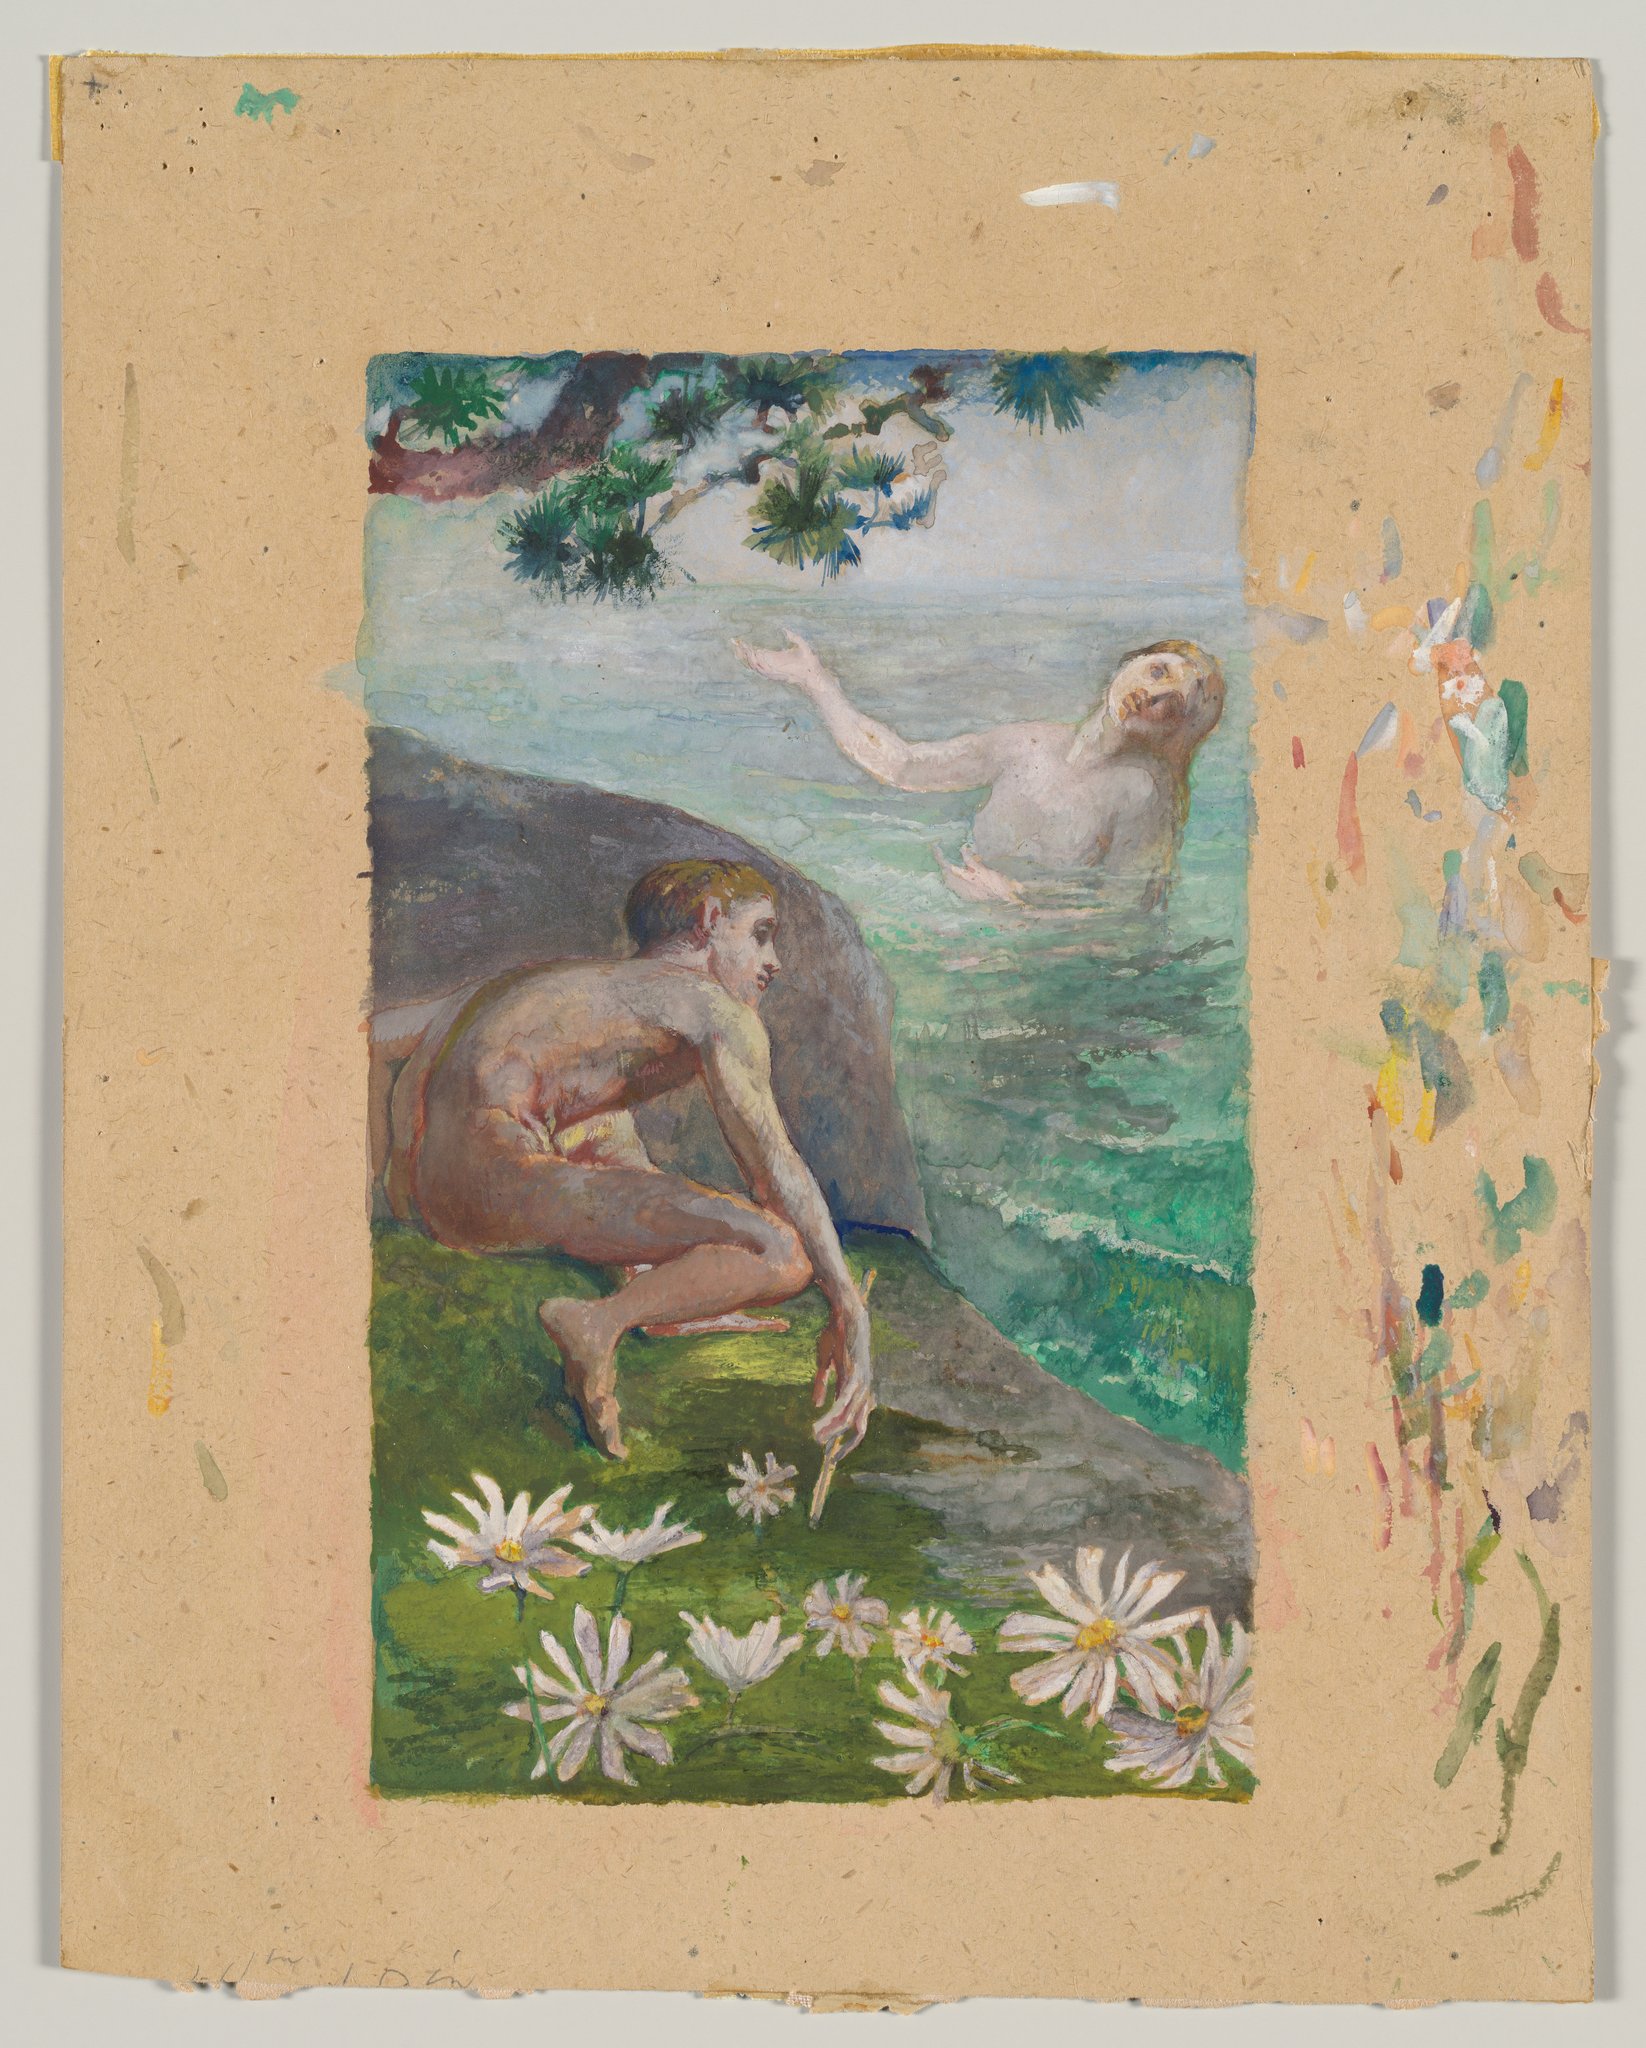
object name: watercolor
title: Song of the Siren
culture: american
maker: john la farge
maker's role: artist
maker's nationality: american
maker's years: 1835-1910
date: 1883-1884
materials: gouache, paper, watercolor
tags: male nudes,female nudes